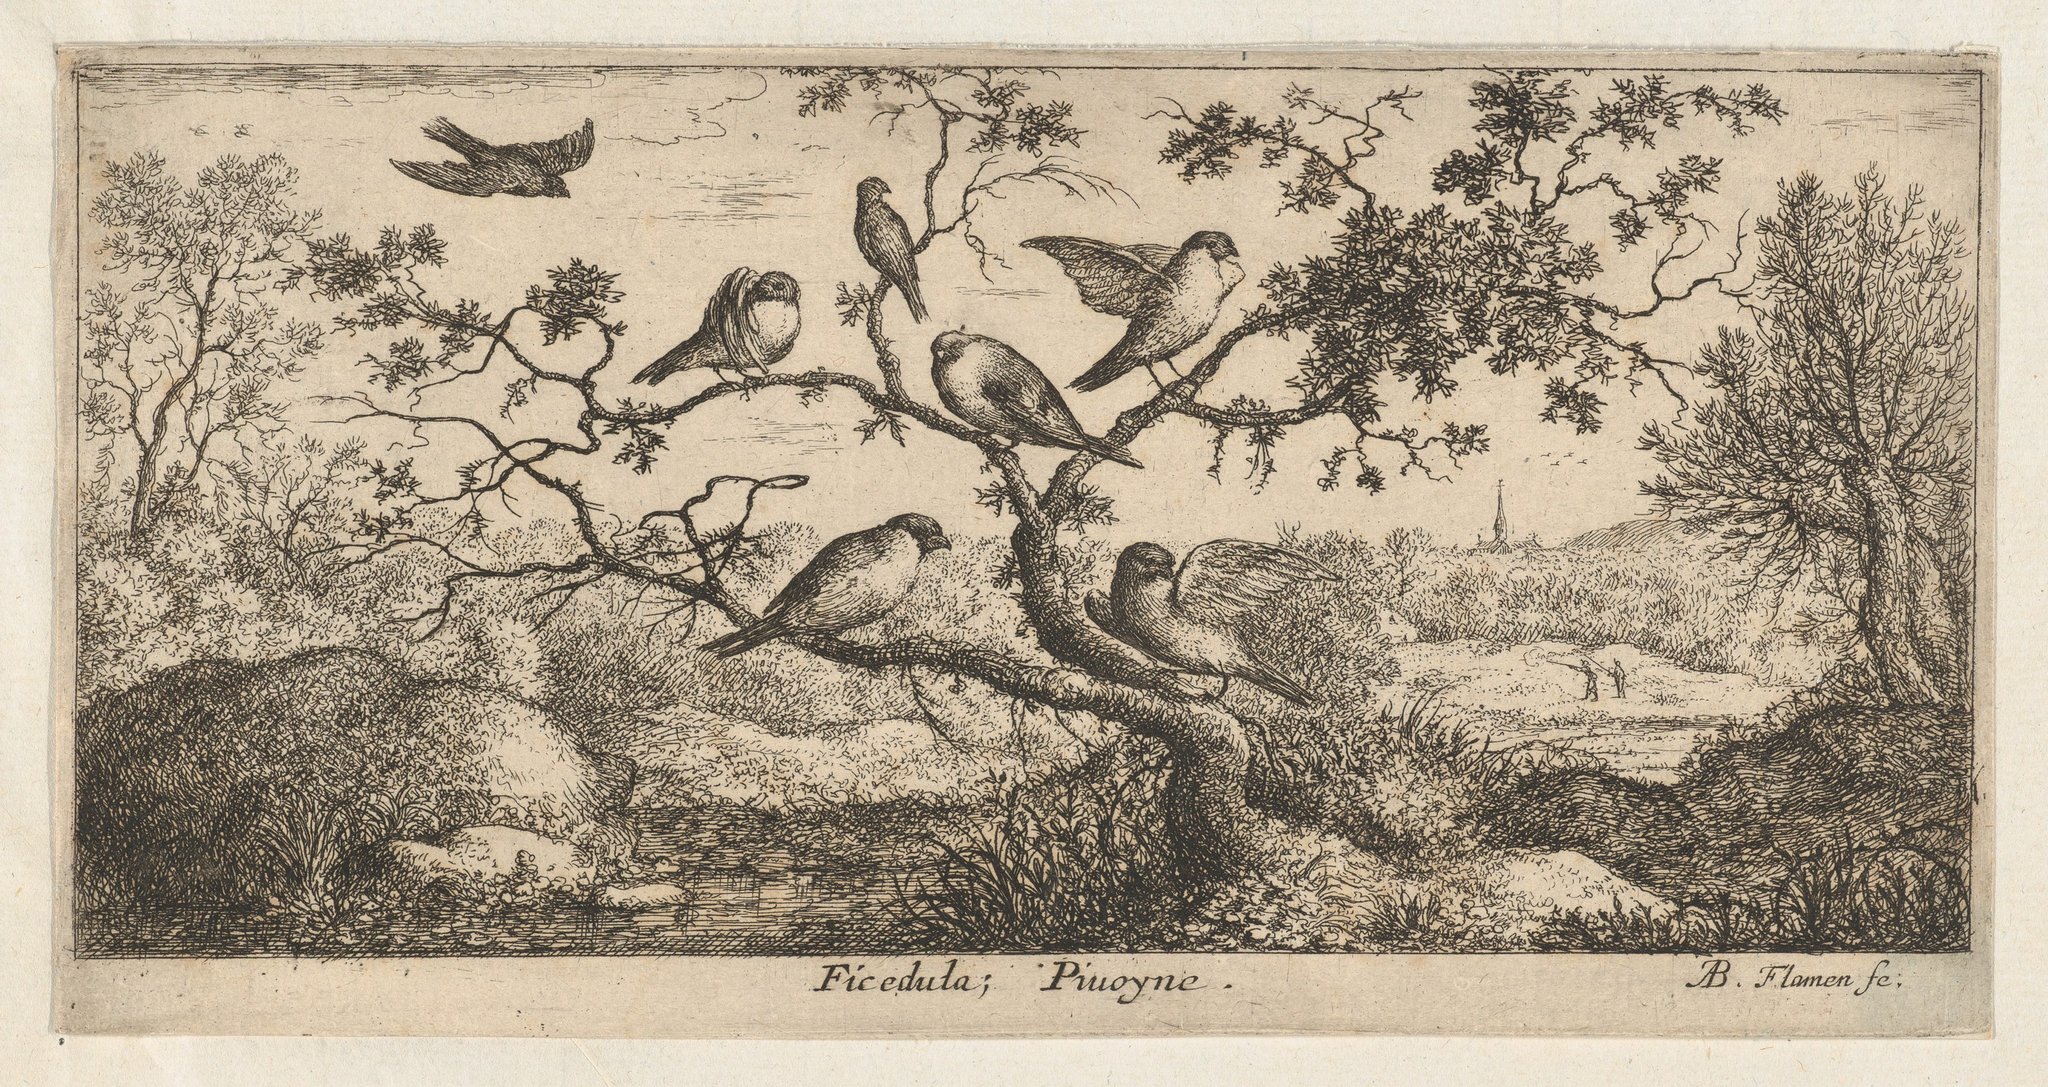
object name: print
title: Ficedula, Piuoyne (The Bullfinch), from "Livre d'Oyseaux" (Book of Birds)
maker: albert flamen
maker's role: artist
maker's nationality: flemish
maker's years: 1615-1688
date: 1655-1660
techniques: etching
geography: france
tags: birds,trees